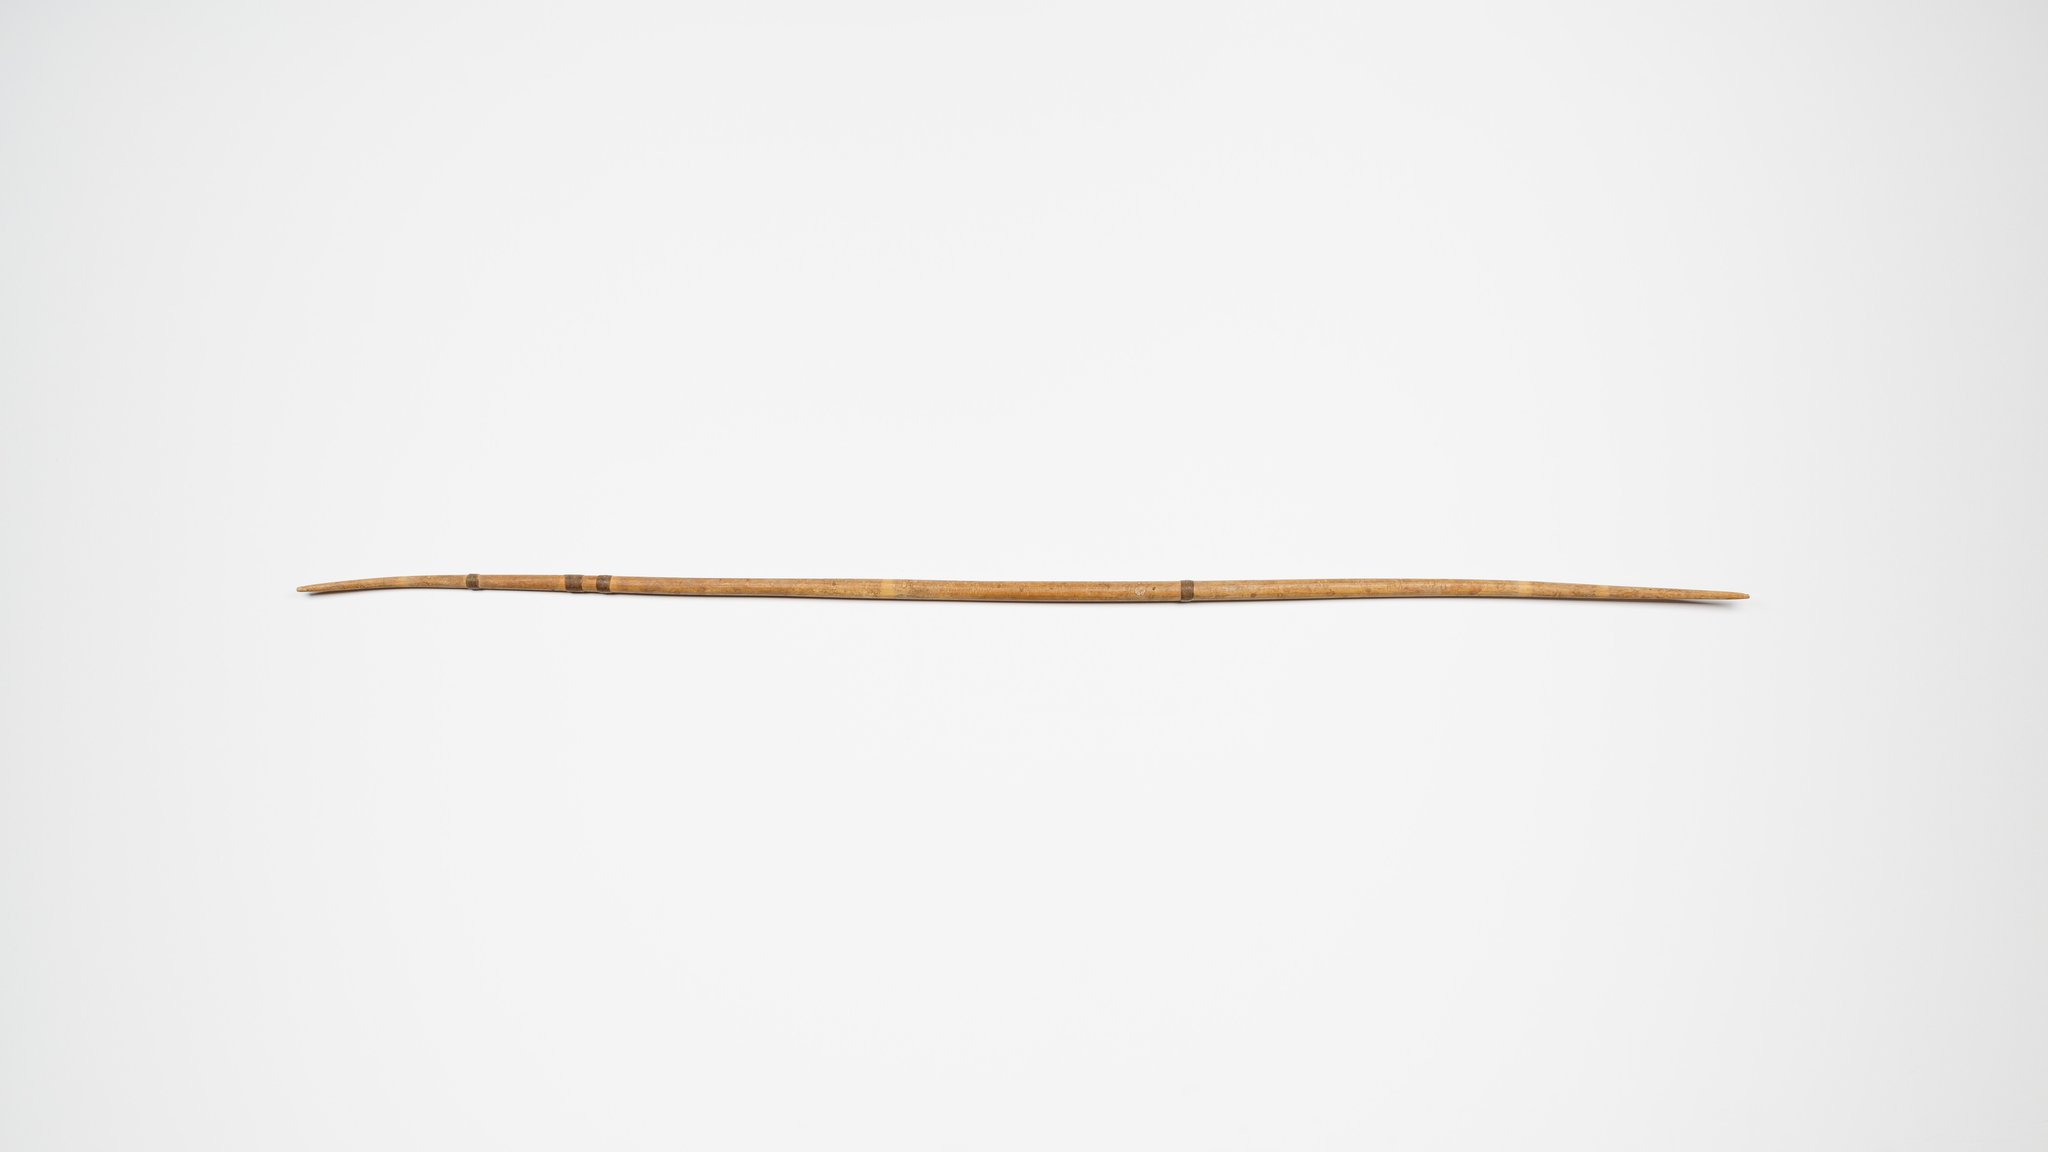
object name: bow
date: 1981-1802 BCE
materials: wood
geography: egypt